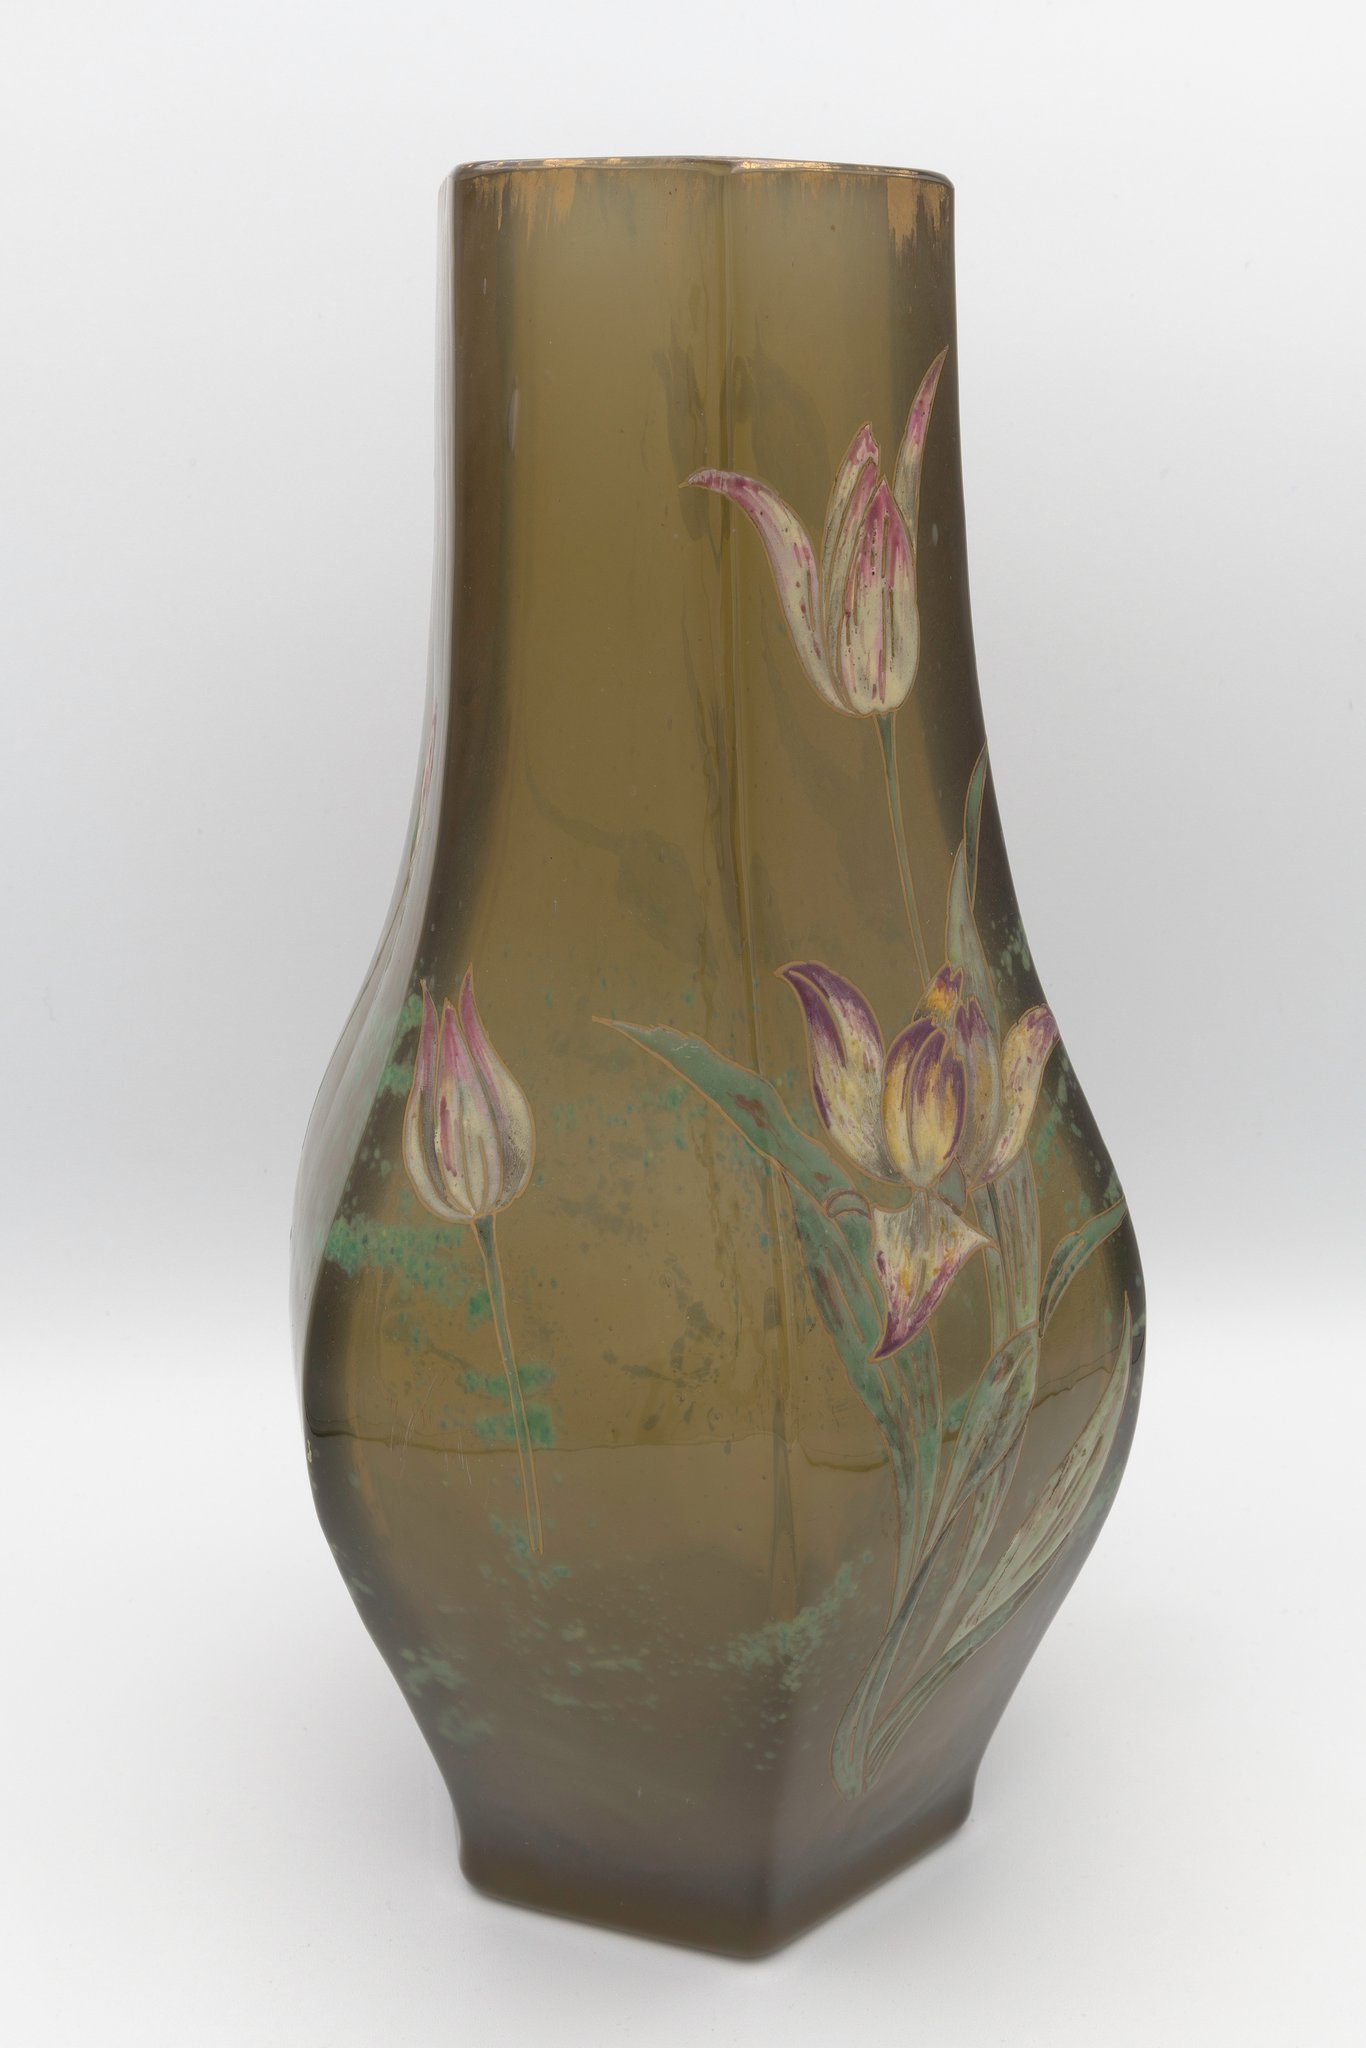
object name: vase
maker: emile gallé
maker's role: designer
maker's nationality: french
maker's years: 1846-1904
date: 1890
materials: enamel, glass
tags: flowers